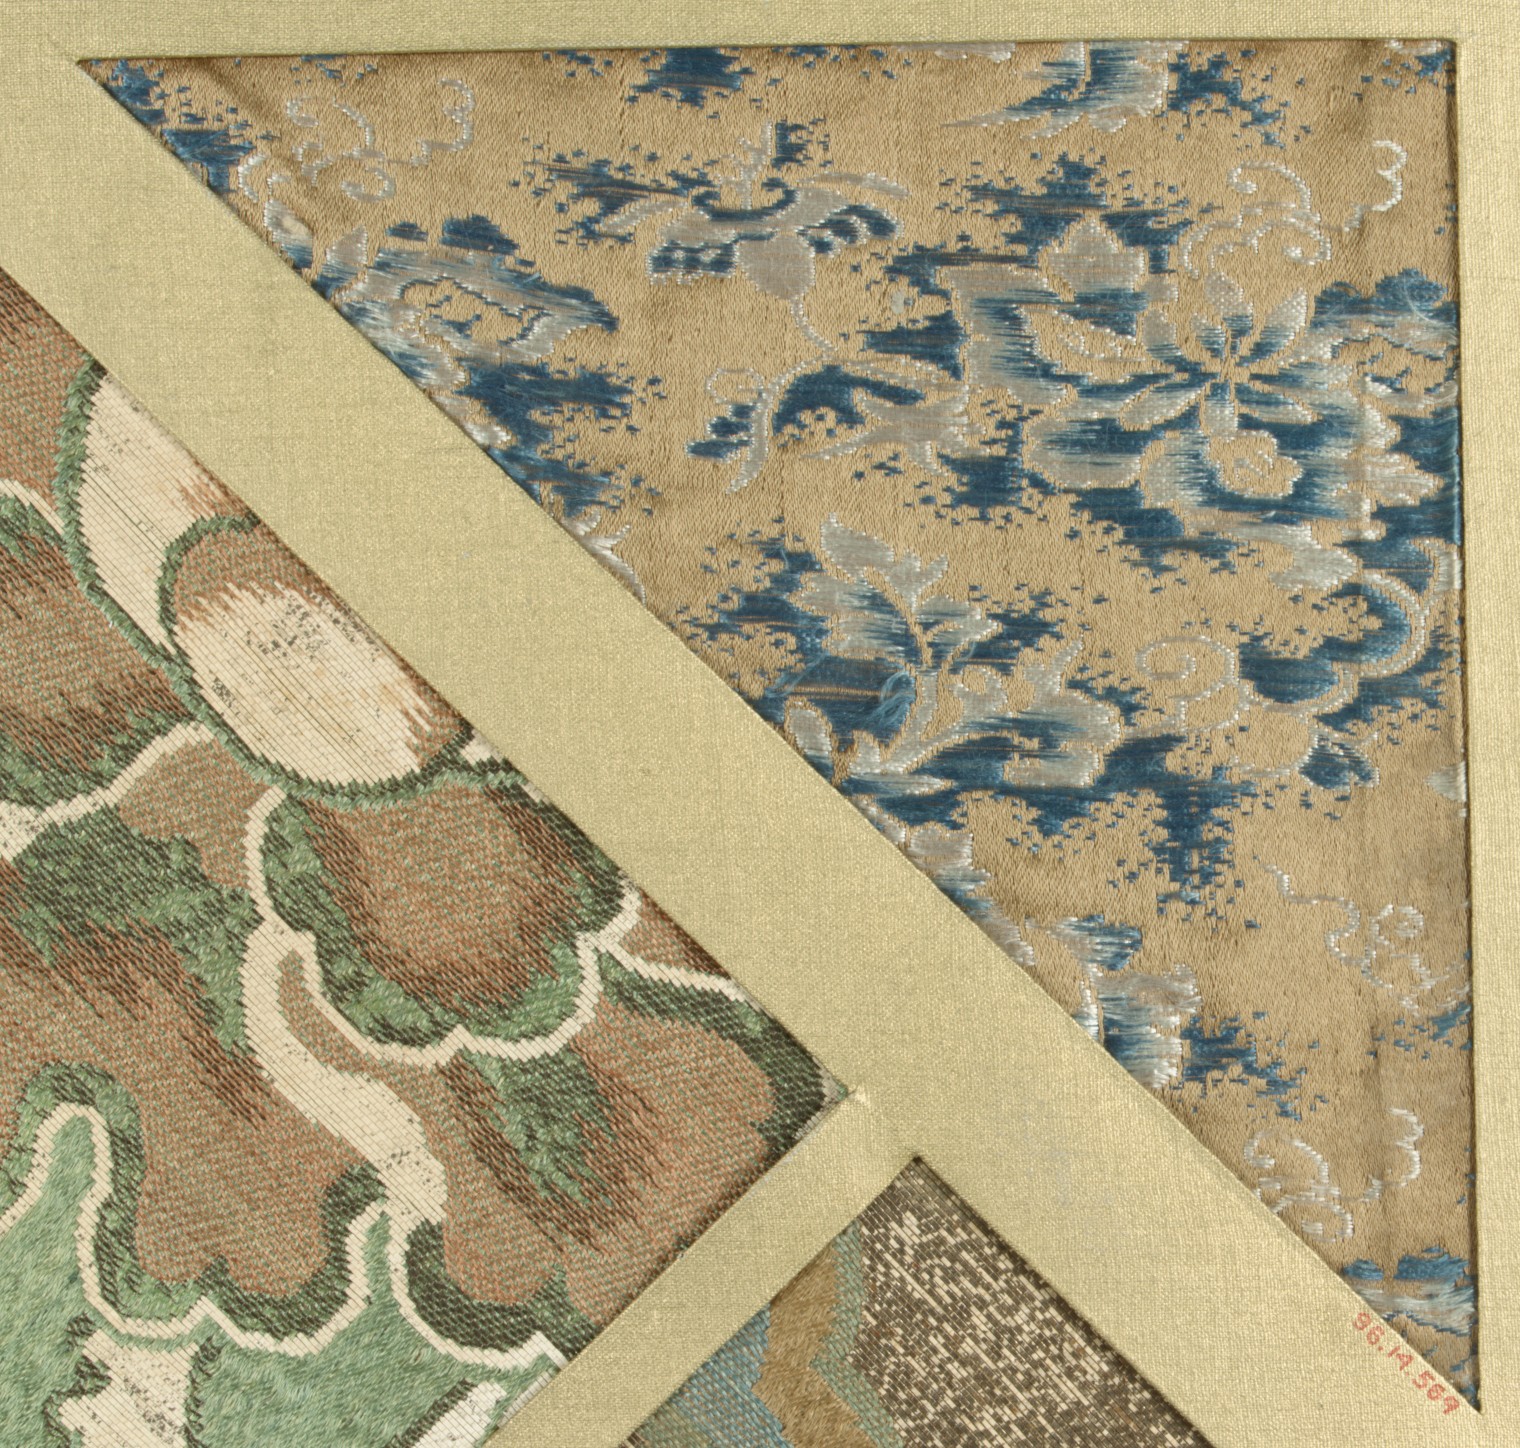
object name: piece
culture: japanese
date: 1701-1900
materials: silk